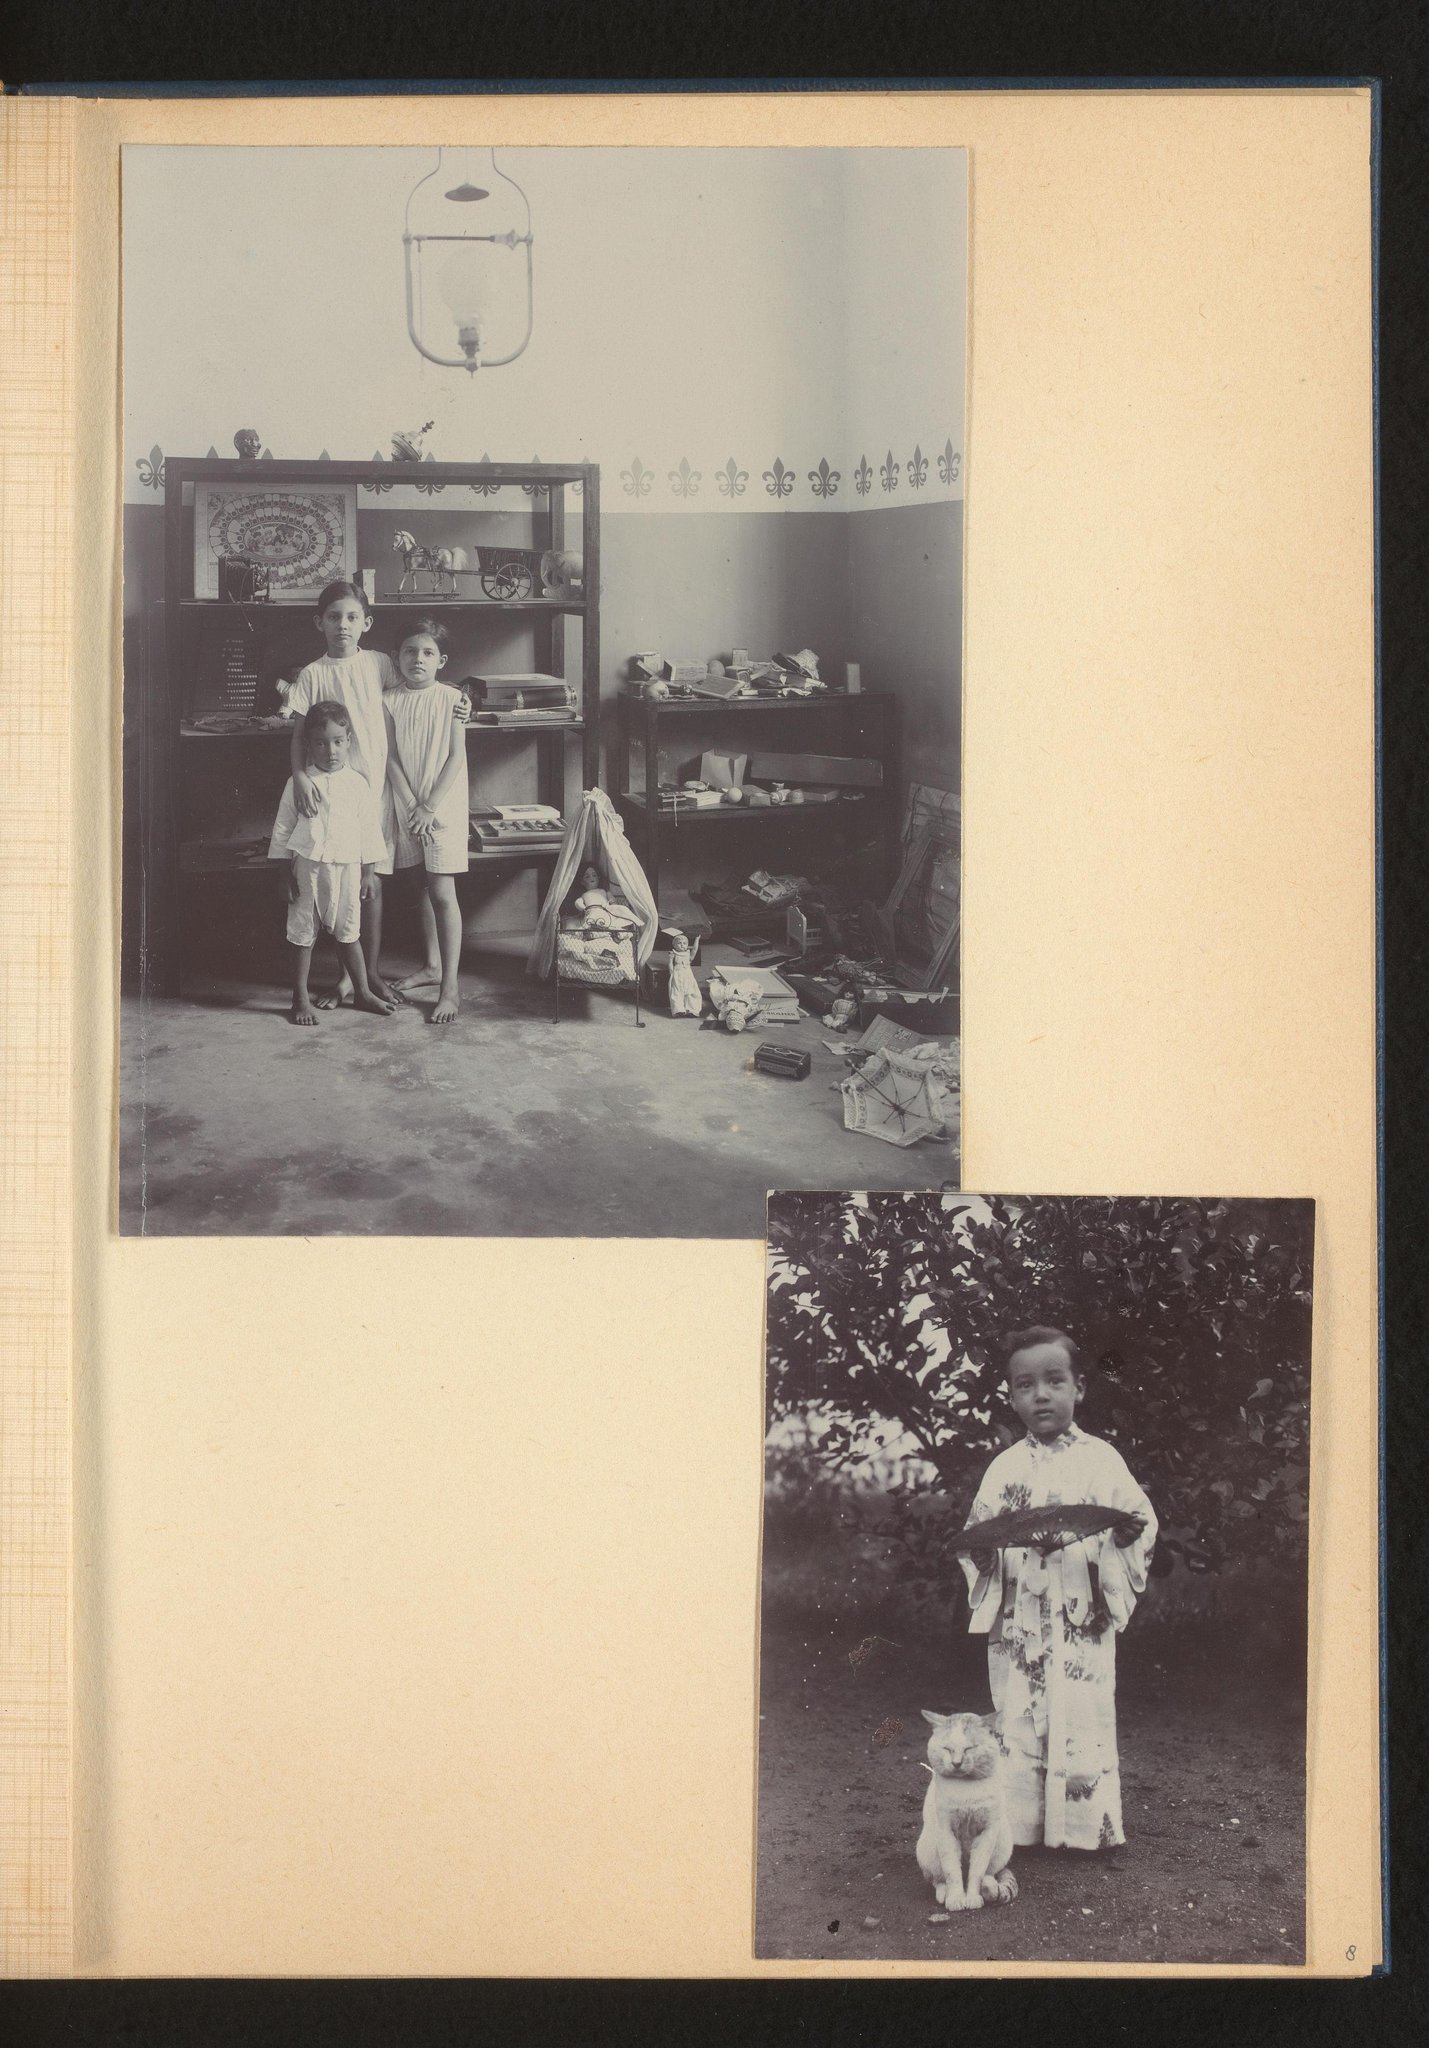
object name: photograph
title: Eef en Han Dumas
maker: frédéric gabriël dumas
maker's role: engineer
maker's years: 1886-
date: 1918-1920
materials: cardboard, photographic support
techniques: gelatin silver print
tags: paris, beatrice jacqueline eveline dumas, historical persons - bb - woman, historical persons, family life at home, toddler - aa - girl, netherlands, dutch east indies, the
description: Blad met twee foto's van Eef Dumas met haar oudere broer Han: samen met een derde kind in de speelkamer en alleen staande met waaier en kat in de tuin. Onderdeel van het fotoalbum van Beatrice Jacqueline Eveline (Eef) Dumas, ca. 1880-1952.